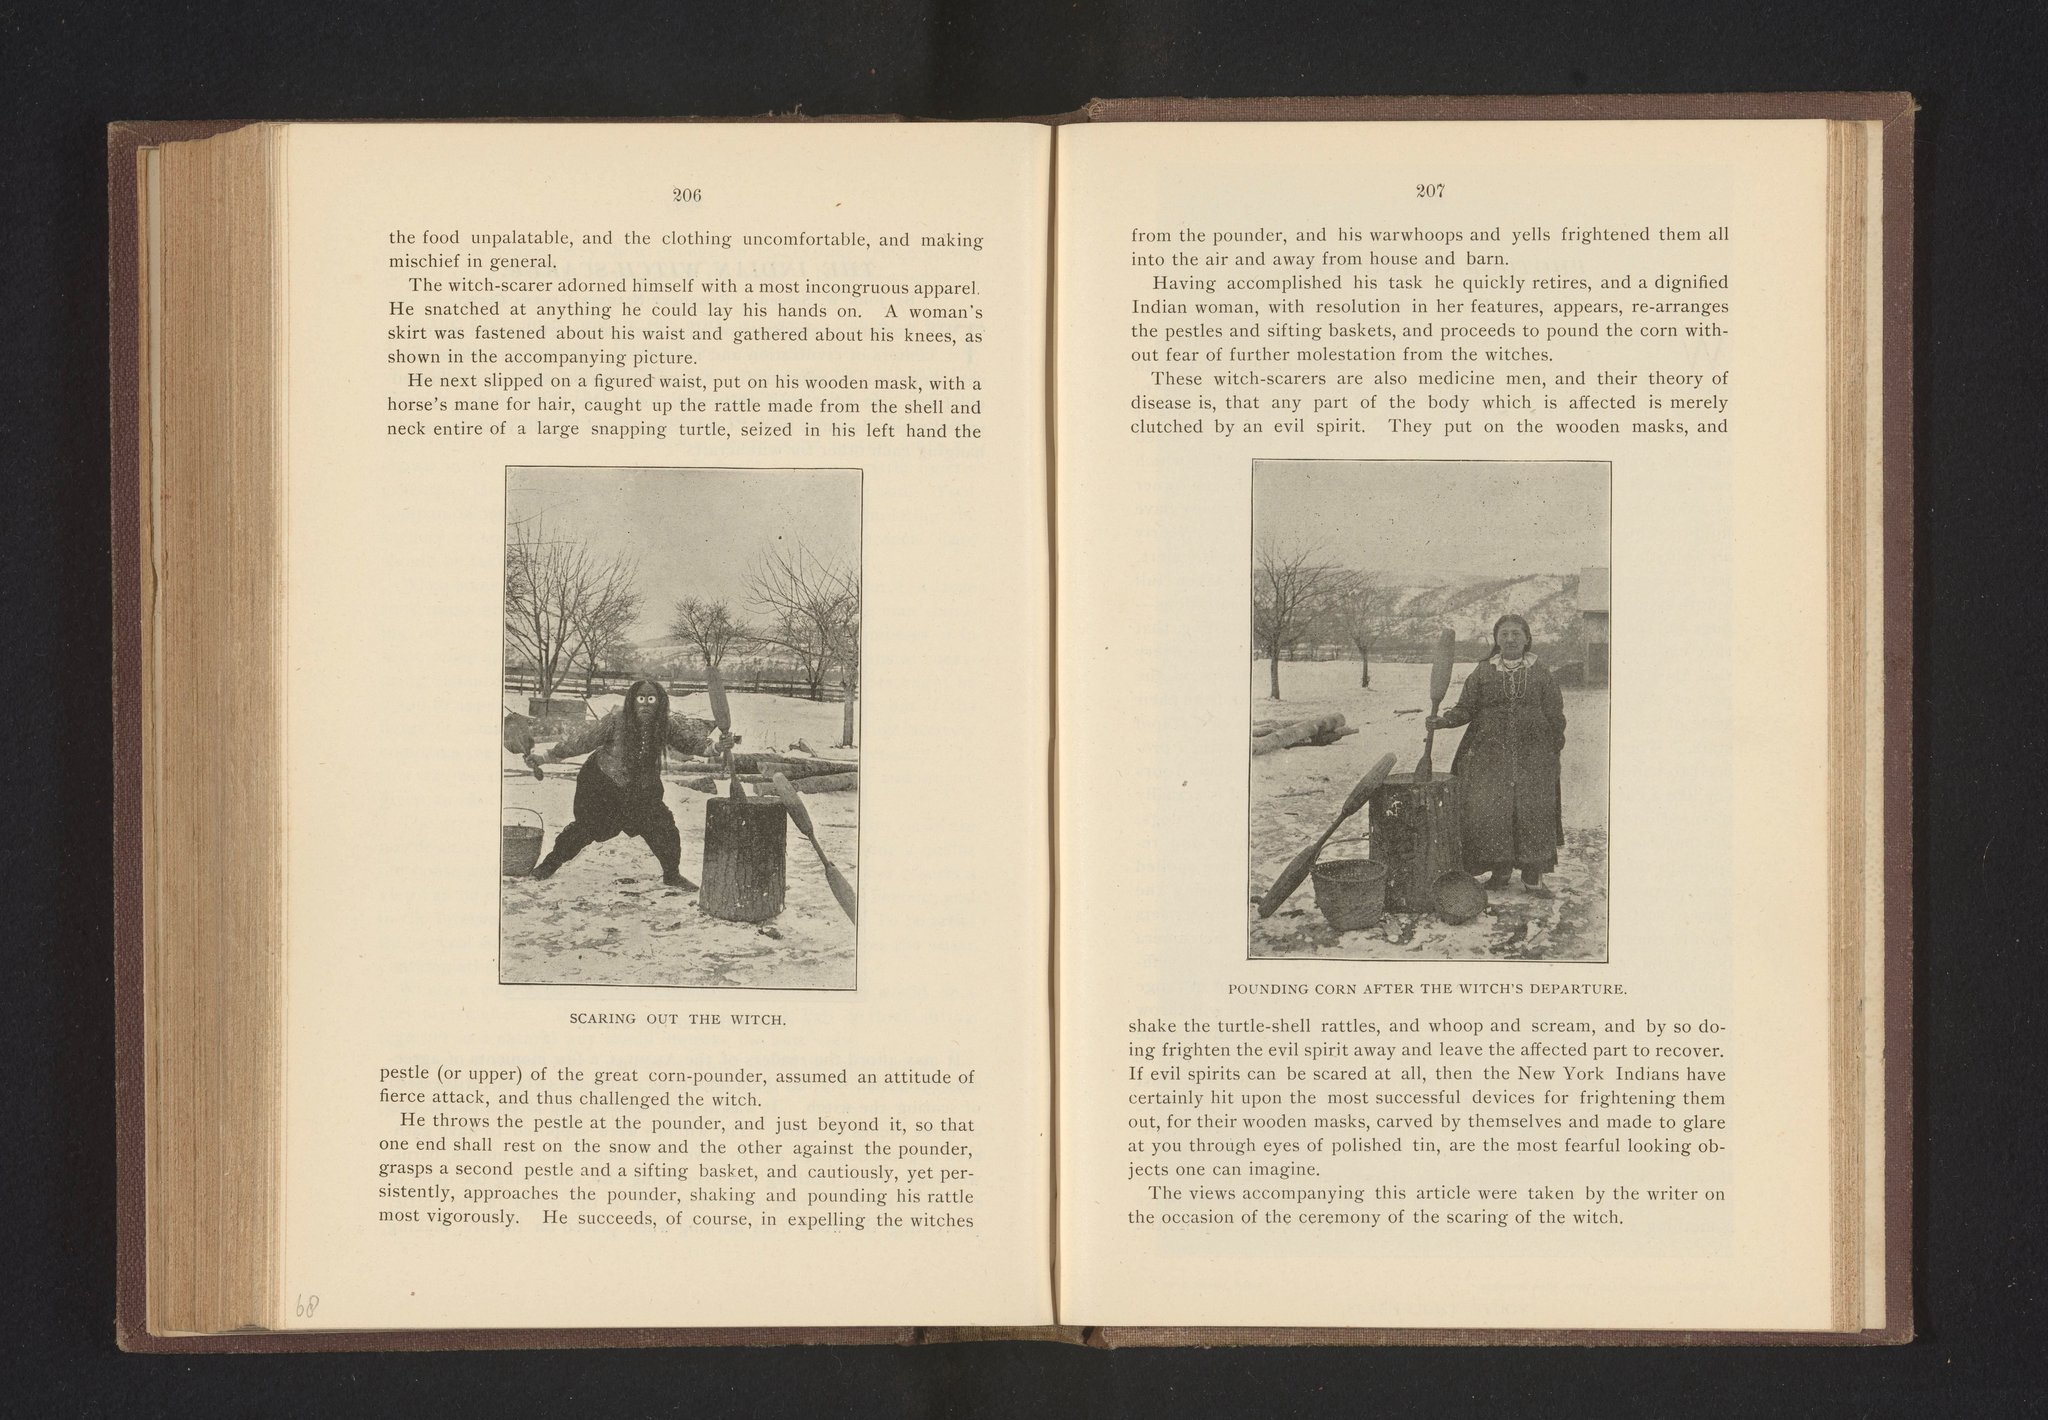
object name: page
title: Pounding corn after the witch's departure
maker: Anonymous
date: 1890-1895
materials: paper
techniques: autotype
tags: adult woman, cereal, grain, corn (grass with grains, grown for food, e.g.: wheat, rice, rye, oats, maize, buckwheat, millet)